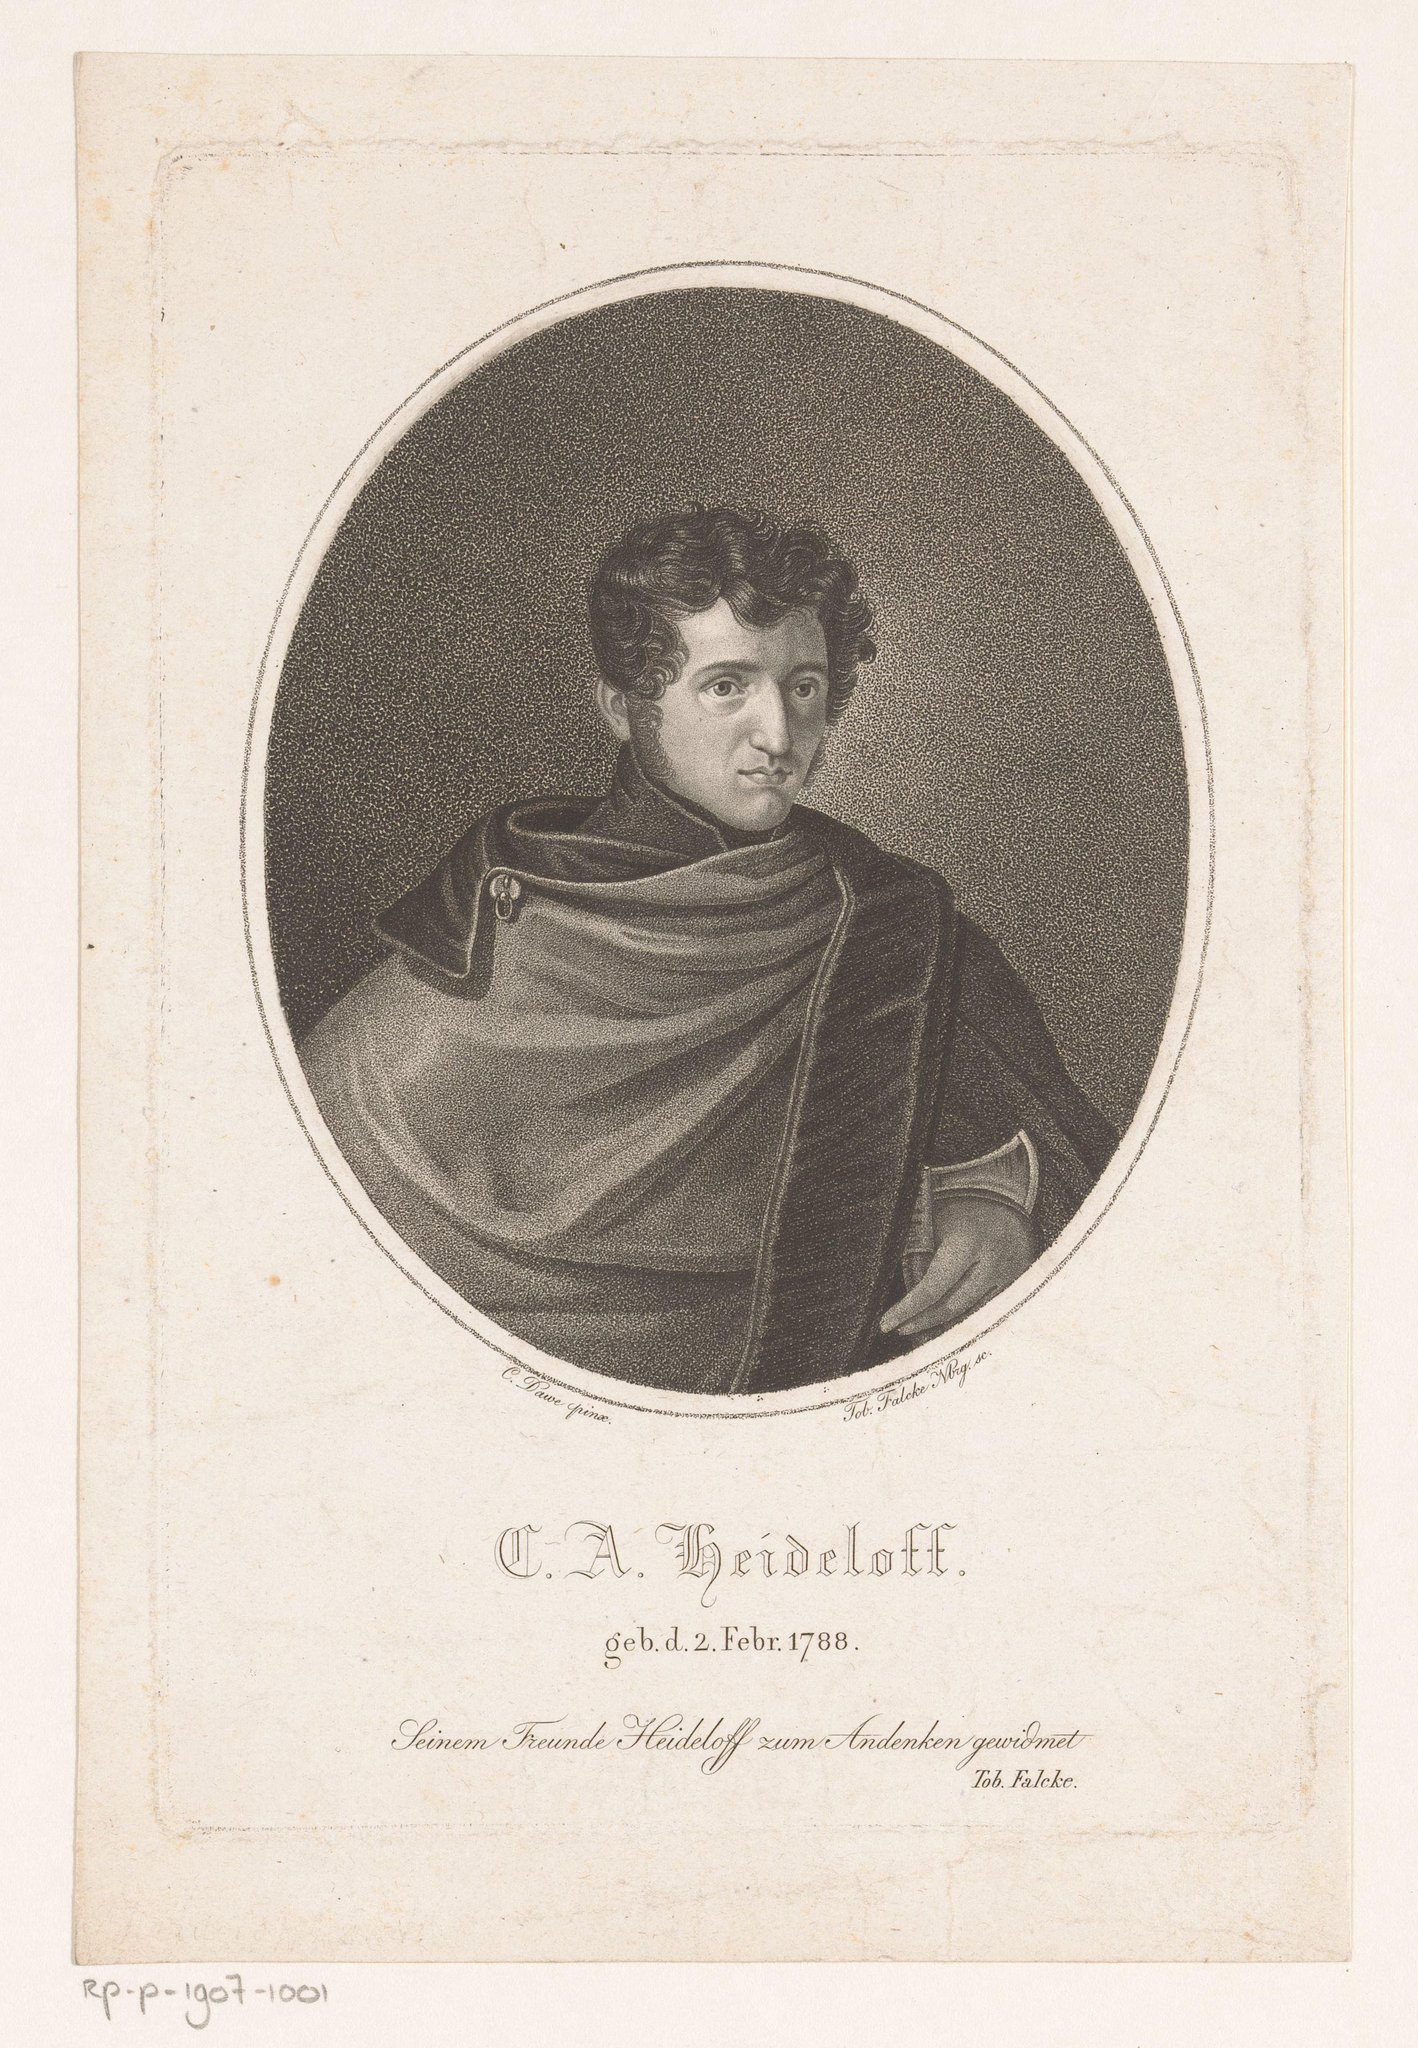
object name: print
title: Portret van Karl Alexander von Heideloff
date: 1800-1830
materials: paper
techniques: stippling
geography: nuremberg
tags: painter, sculptor, conservator, tools, aids, implements ~ crafts and industries: chisel, historical persons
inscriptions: collector's mark: Lugt 2228